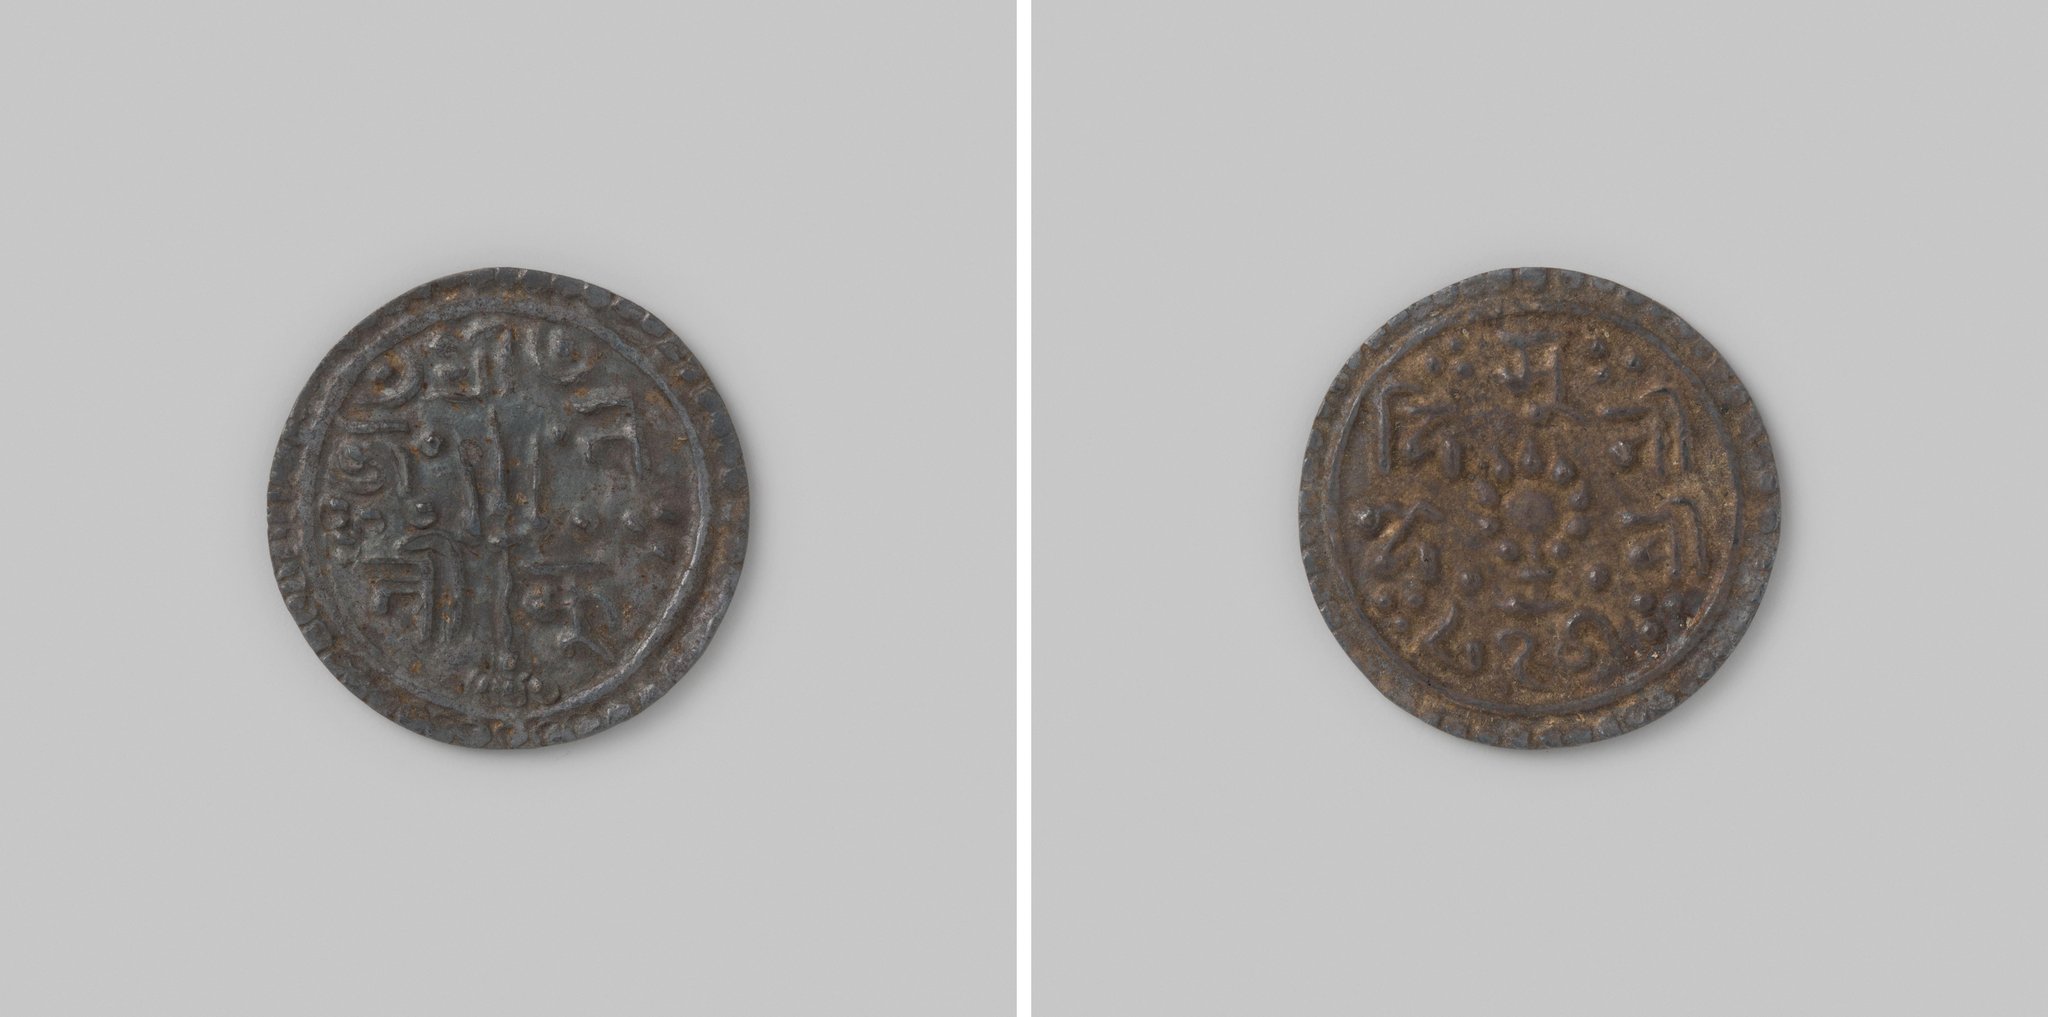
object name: coin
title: Suka of 1/4 mohar uit Nepal van Bhupalendra Malla van Katmandu, 810-816 [= 1689-1695]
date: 1689-1695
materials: silver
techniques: striking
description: Zilveren munt. Voorzijde: rondom stupa tekens in devanagari-schrift. Keerzijde: tekens in devanagari-schrift.